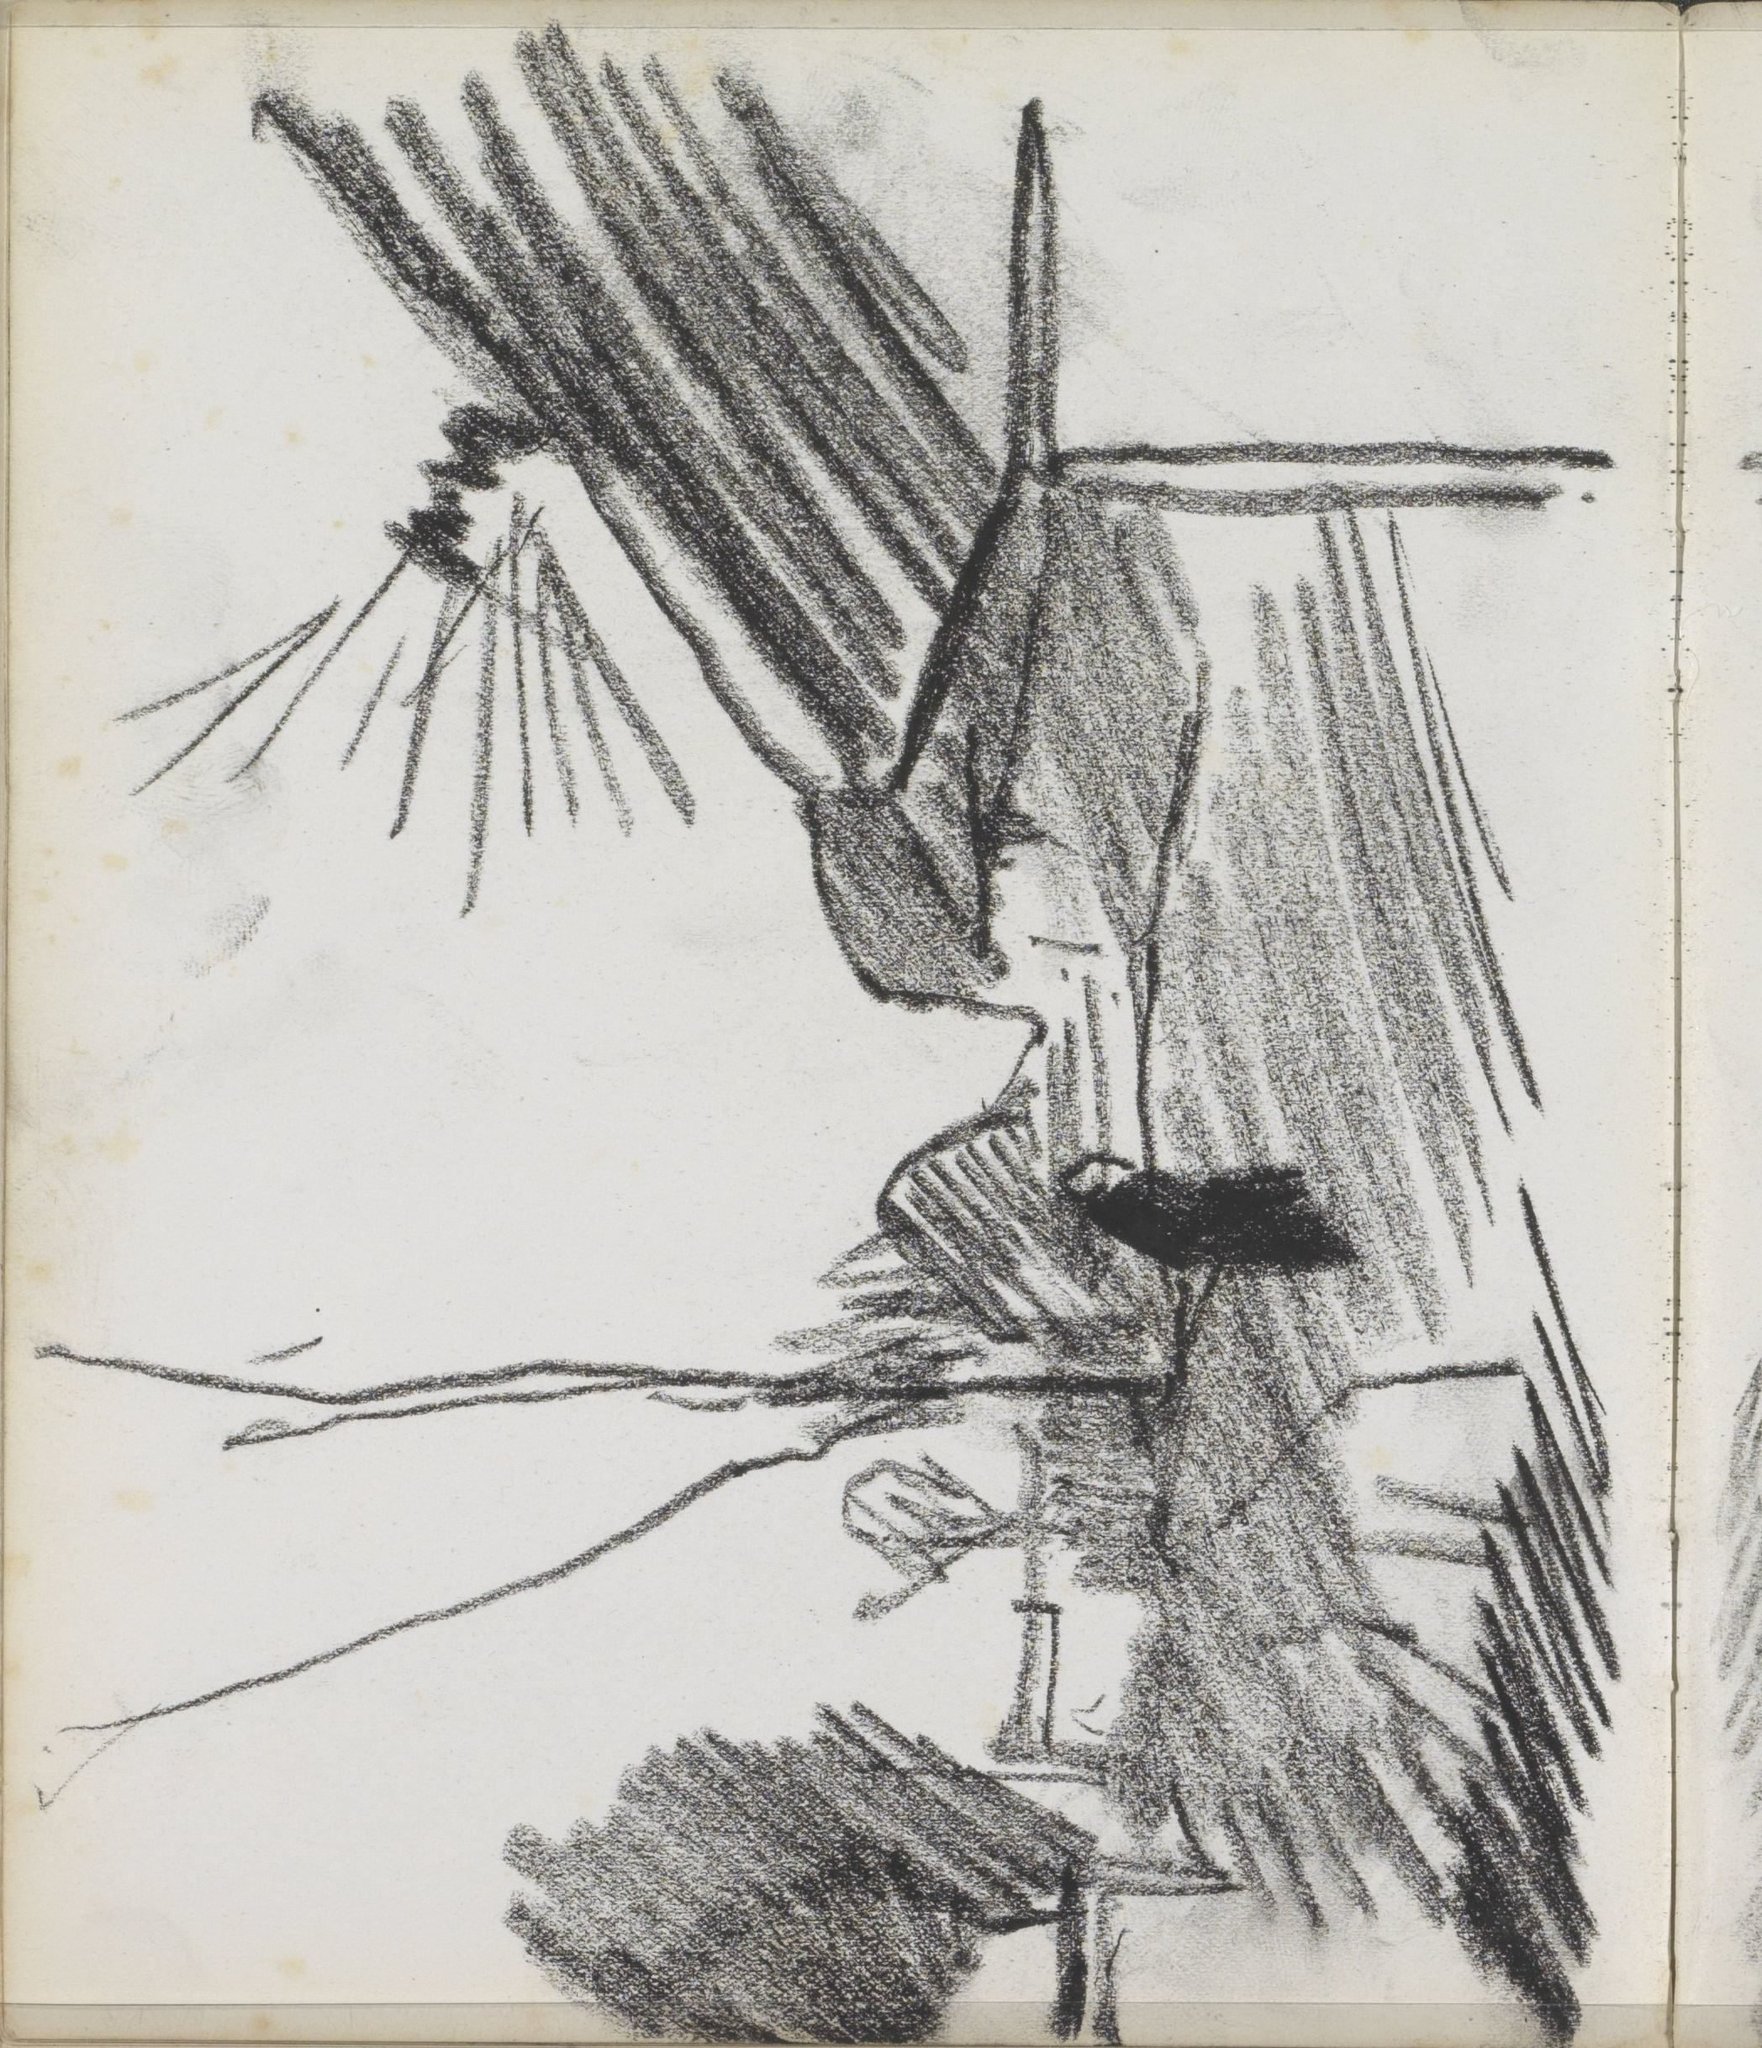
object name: sketchbook leaf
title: Figuur in een landschap met bebouwing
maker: george hendrik breitner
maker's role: draughtsman, painter, print maker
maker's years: 1857-1923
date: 1880-1906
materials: chalk, paper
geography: netherlands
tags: rural housing, e.g. country-house, villa, cottage, landscapes (+ landscape with figures, staffage), farm (building)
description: Mogelijk een boerderij. Pagina 115 uit een schetsboek met 81 bladen.